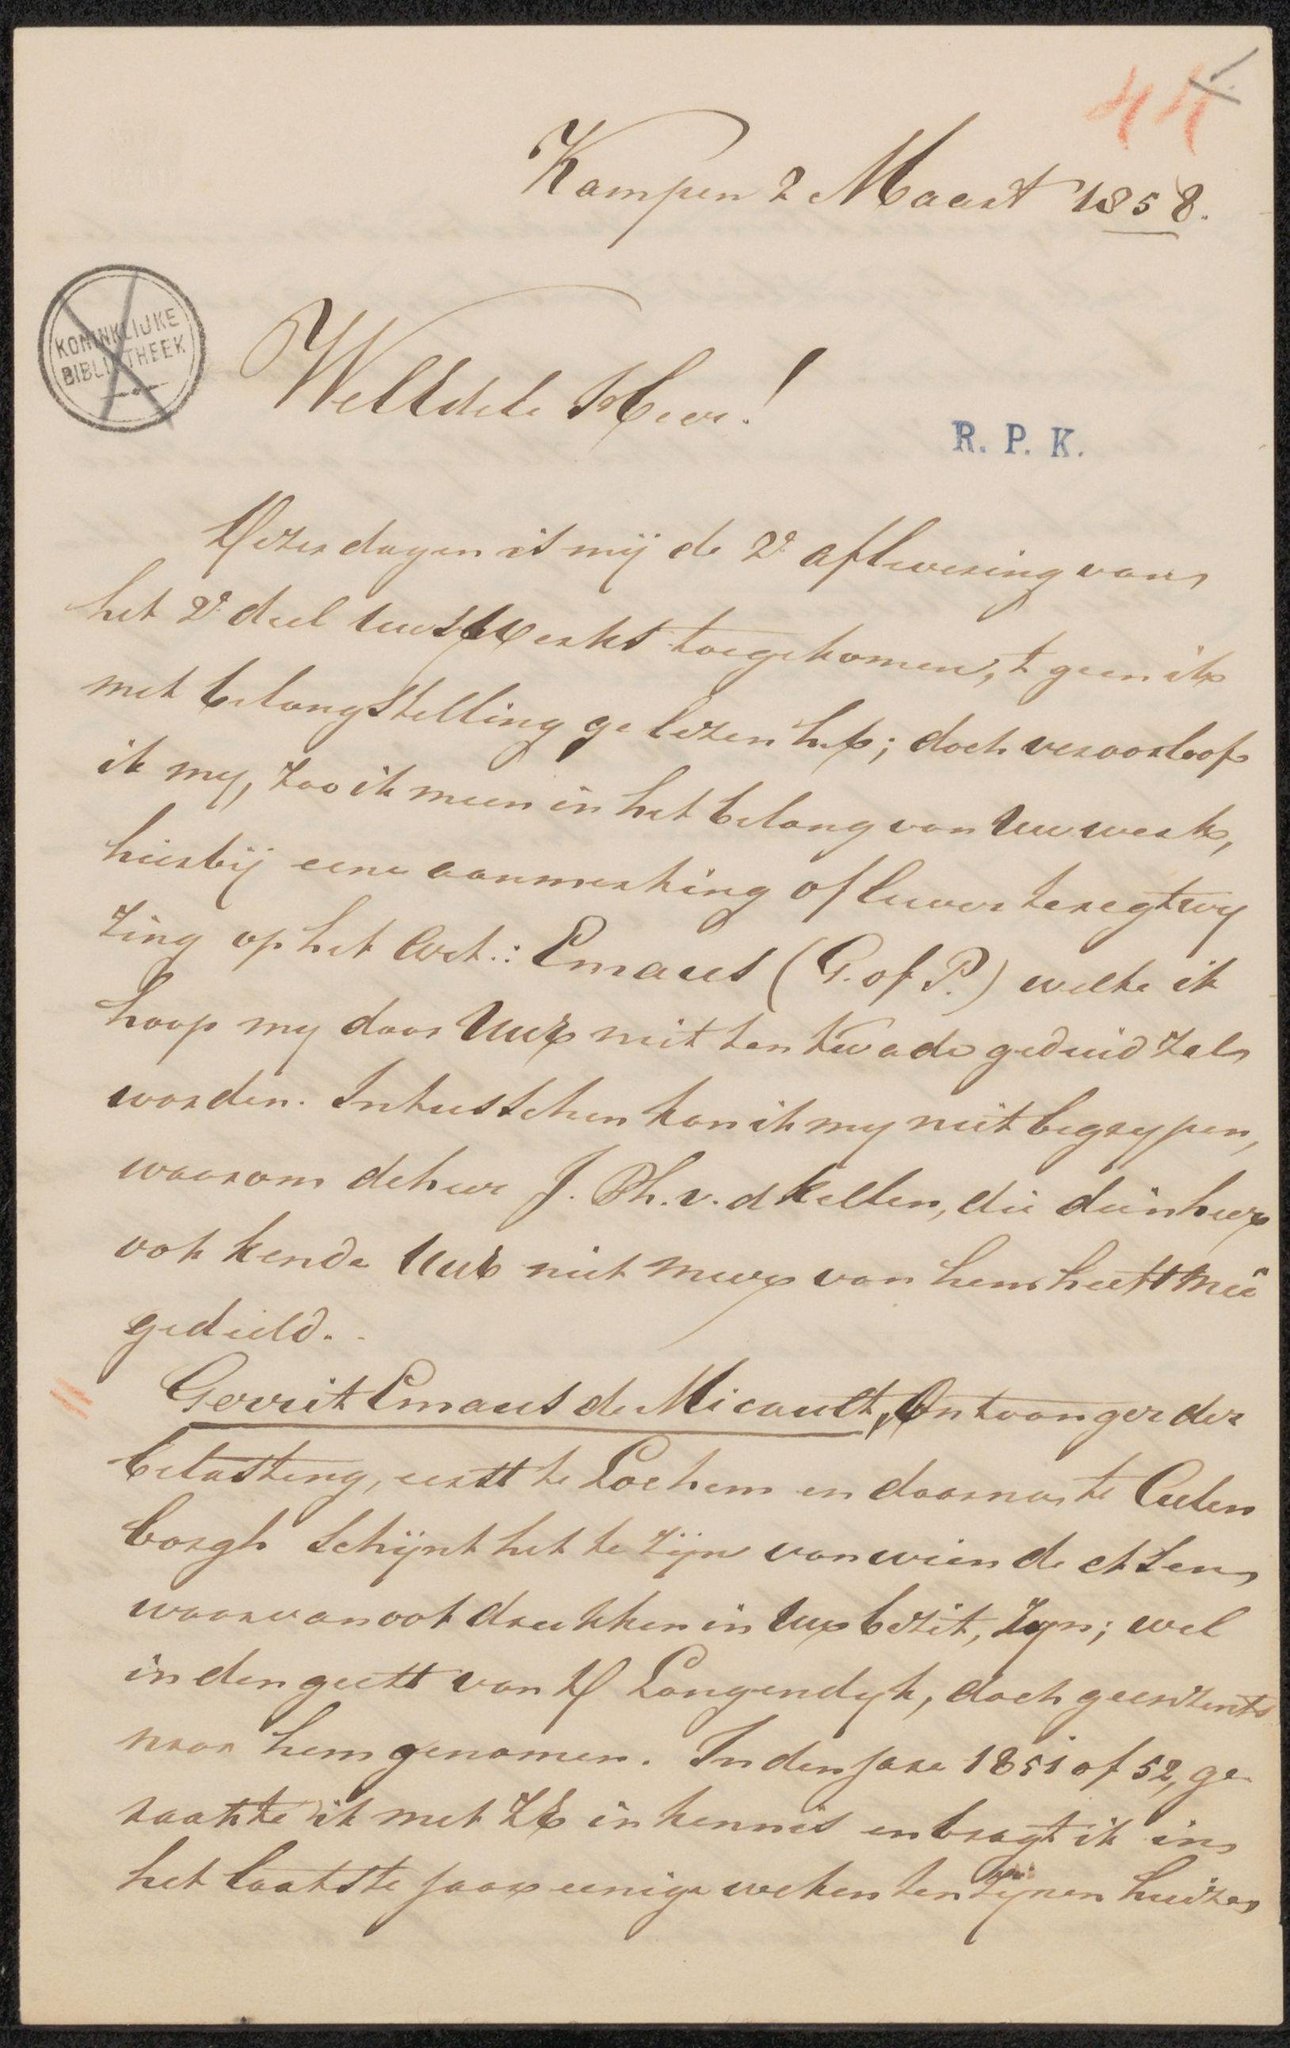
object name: letter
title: Brief aan Christiaan Kramm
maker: jacobus cornelis gaal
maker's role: print maker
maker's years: 1796-1866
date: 1858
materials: ink, paper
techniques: pen, writing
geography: kampen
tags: dordrecht, gouda, print maker, draughtsman, gerardus emaus de micault, ernst willem jan bagelaar, utrecht, christiaan kramm, drawing, the graphic arts, money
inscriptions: collector's mark: ‘KONINKLIJKE BIBLIOTHEEK’, collector's mark: Lugt 2233